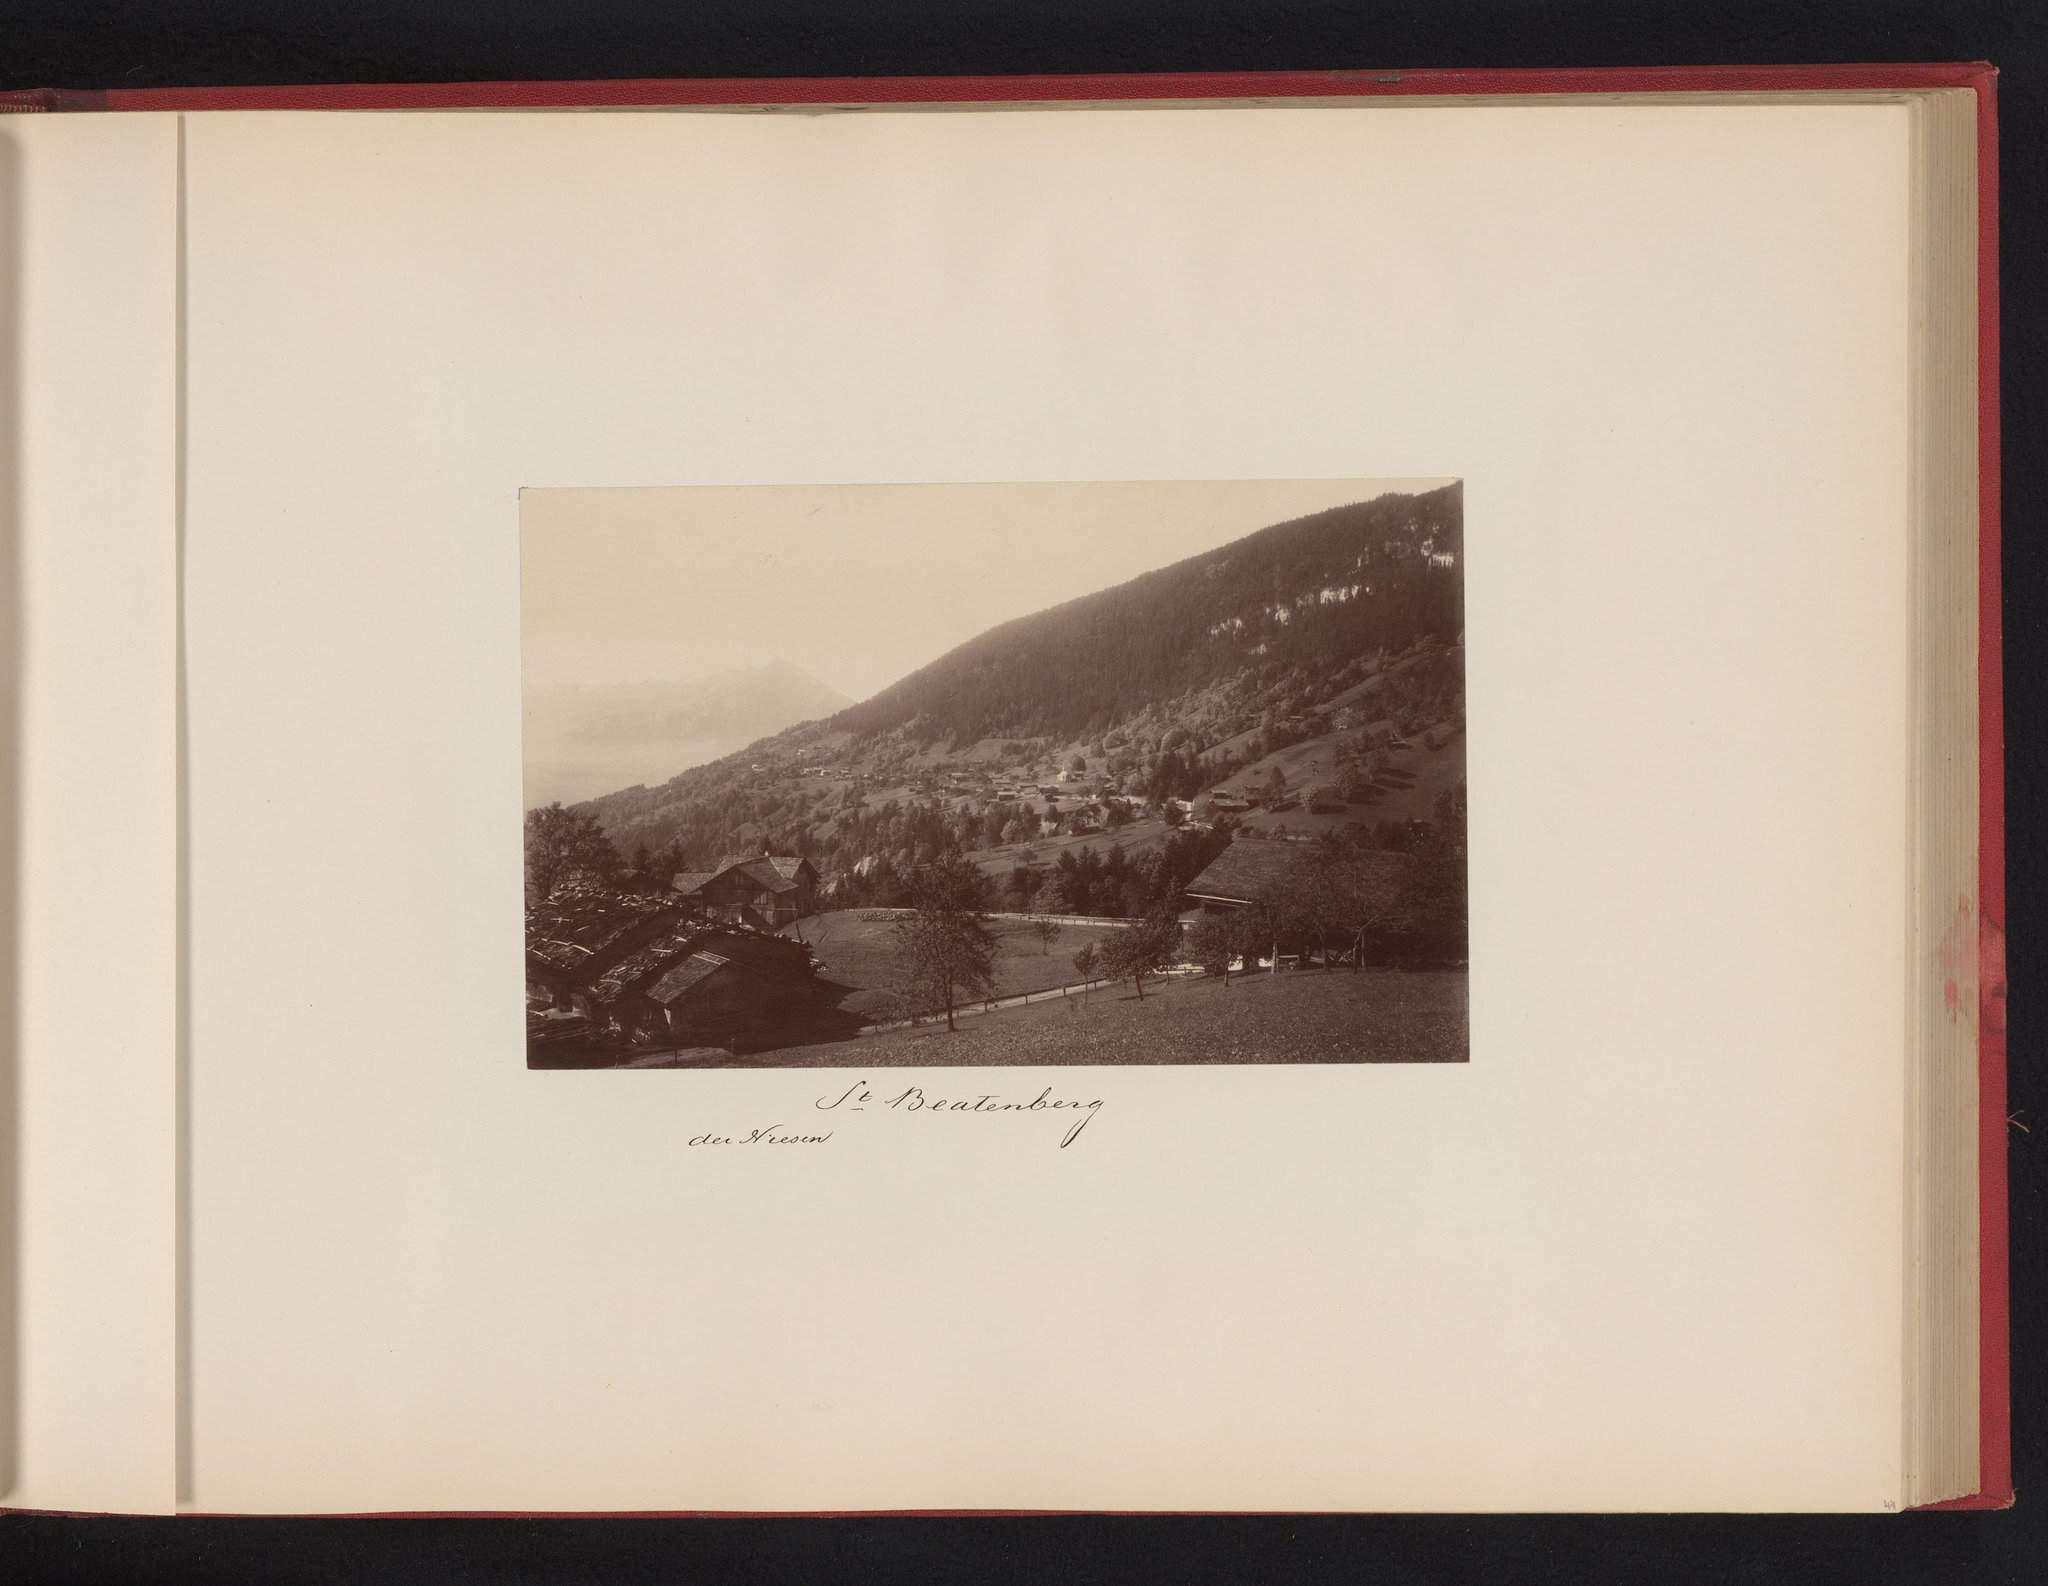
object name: album leaf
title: Gezicht op Beatenberg te Zwitserland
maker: Anonymous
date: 1880-1900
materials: photographic support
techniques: albumen print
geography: beatenberg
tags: city-view in general; 'veduta', mountains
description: Deze prent maakt deel uit van een album.